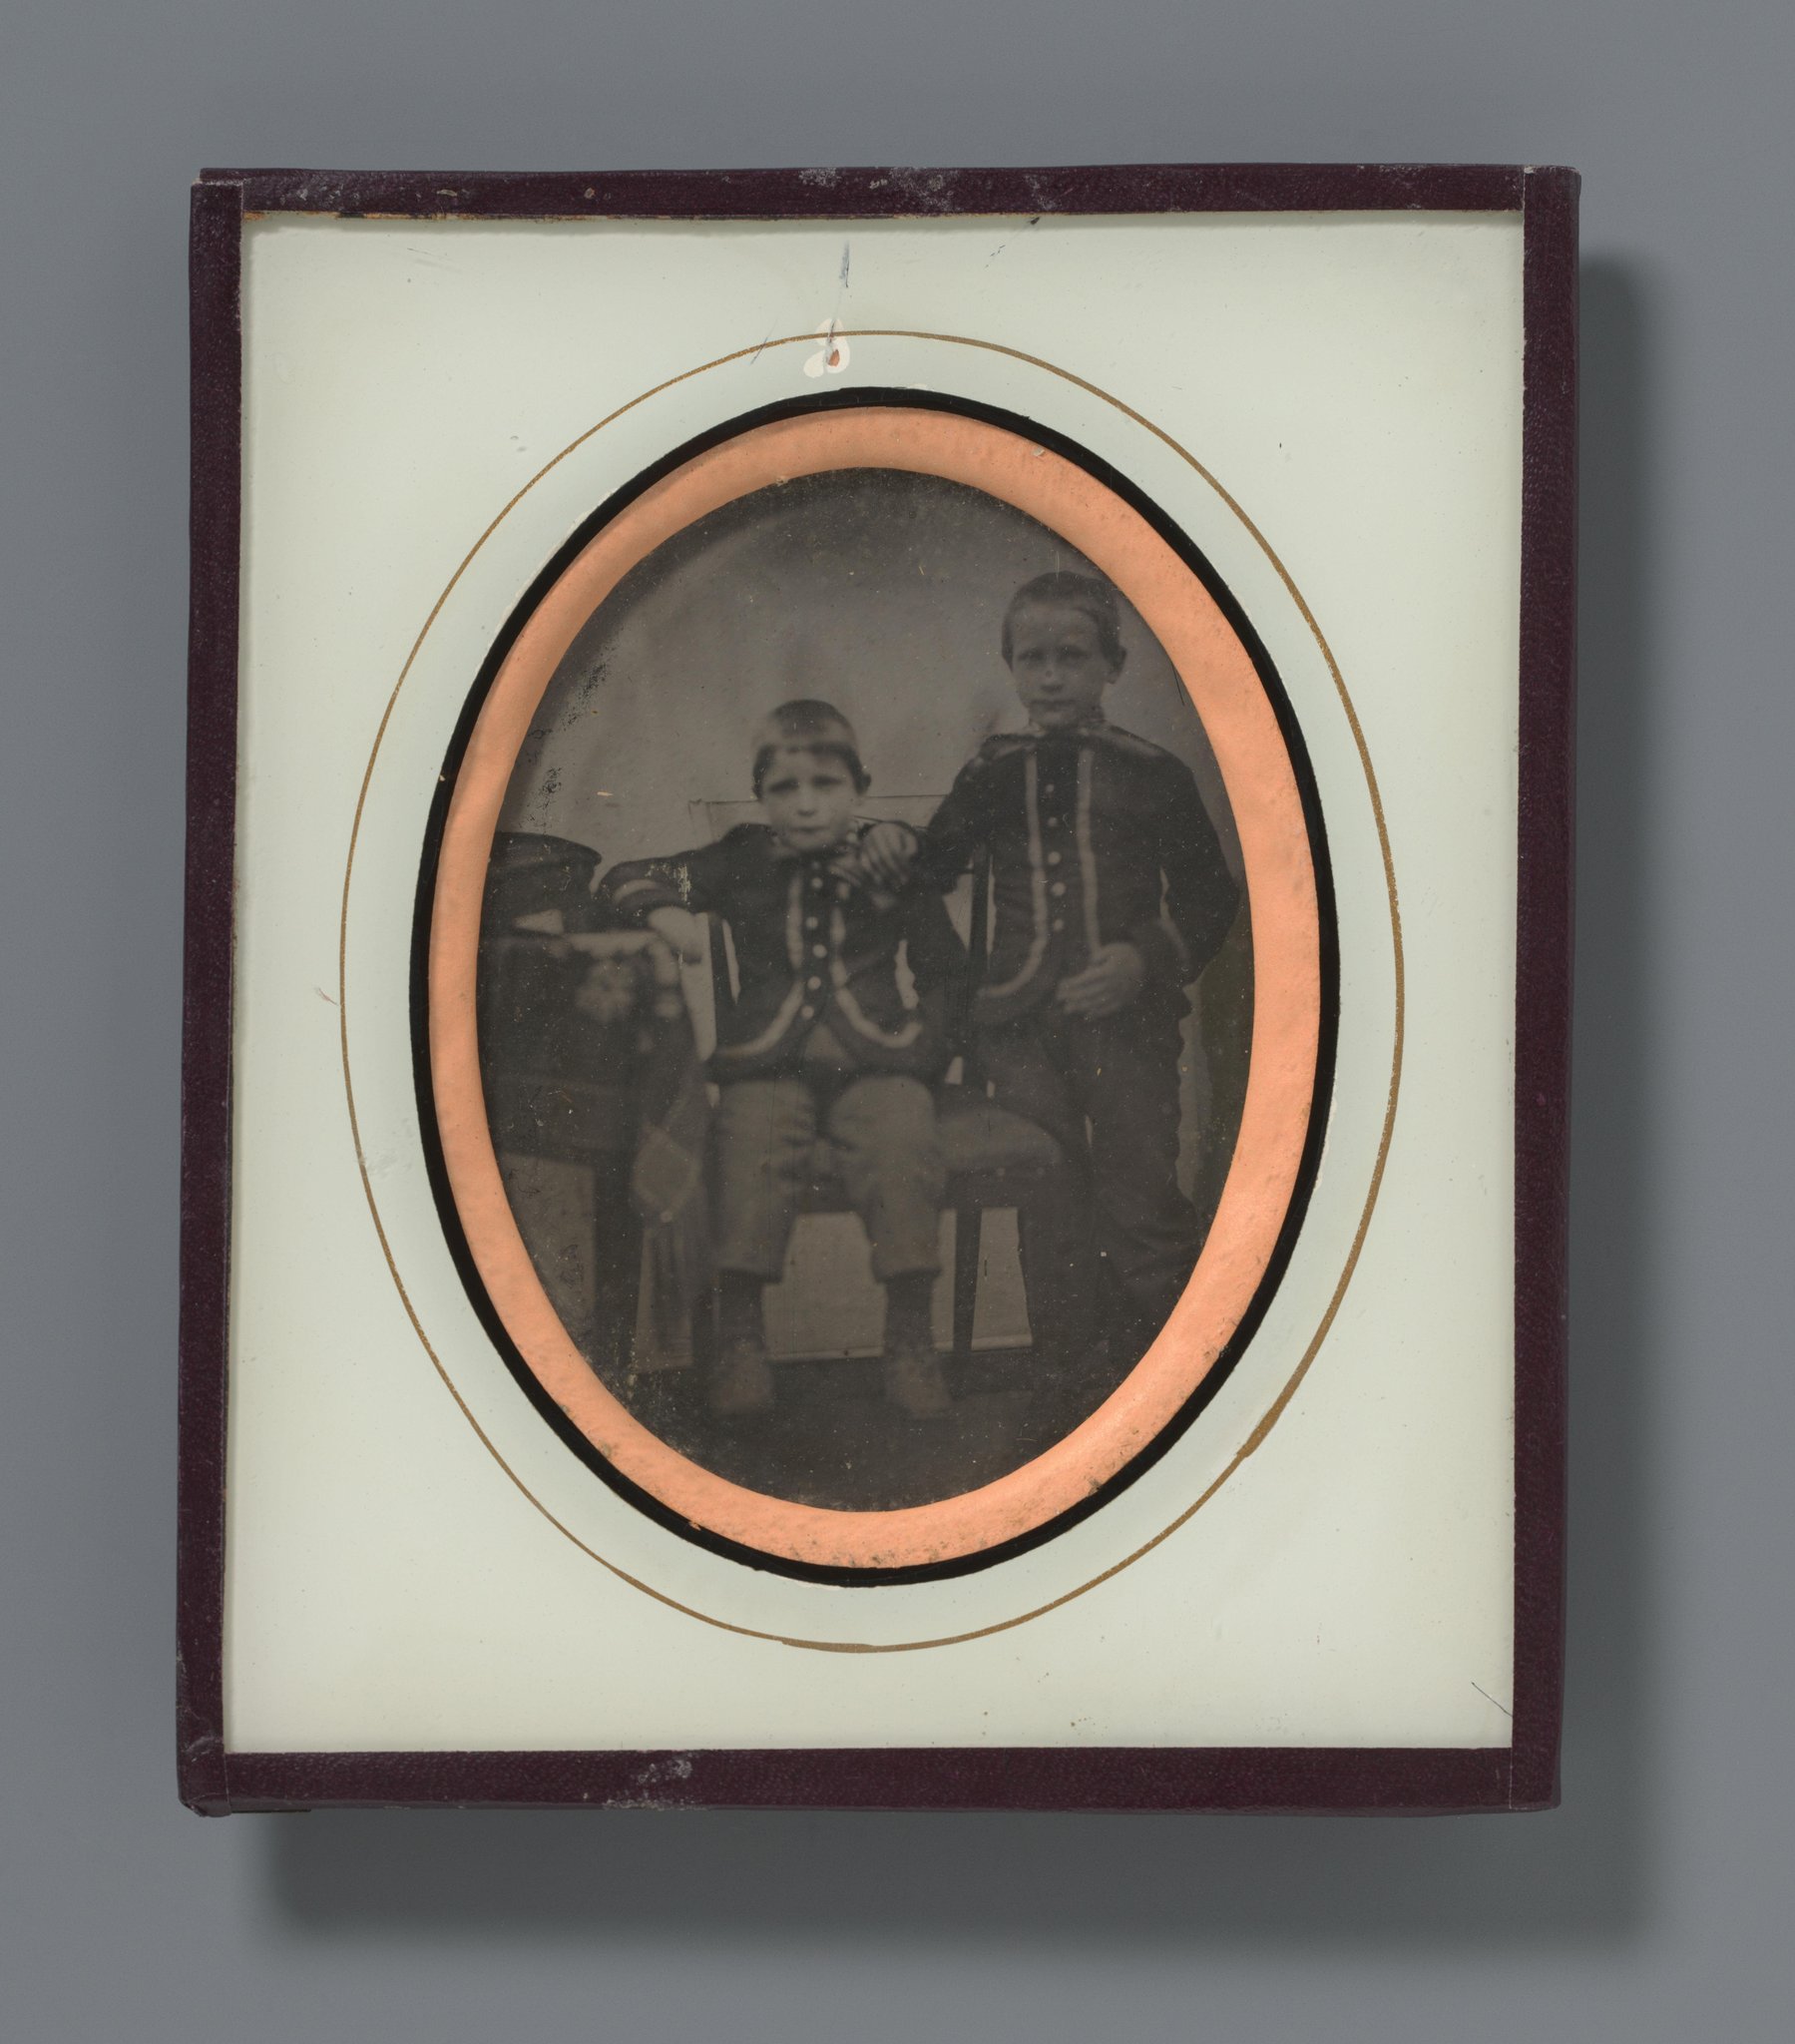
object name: frame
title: Portret van twee onbekende jongens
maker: Anonymous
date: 1855-1870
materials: cardboard, glass, paper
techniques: ambrotype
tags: anonymous historical persons portrayed in a double portrait